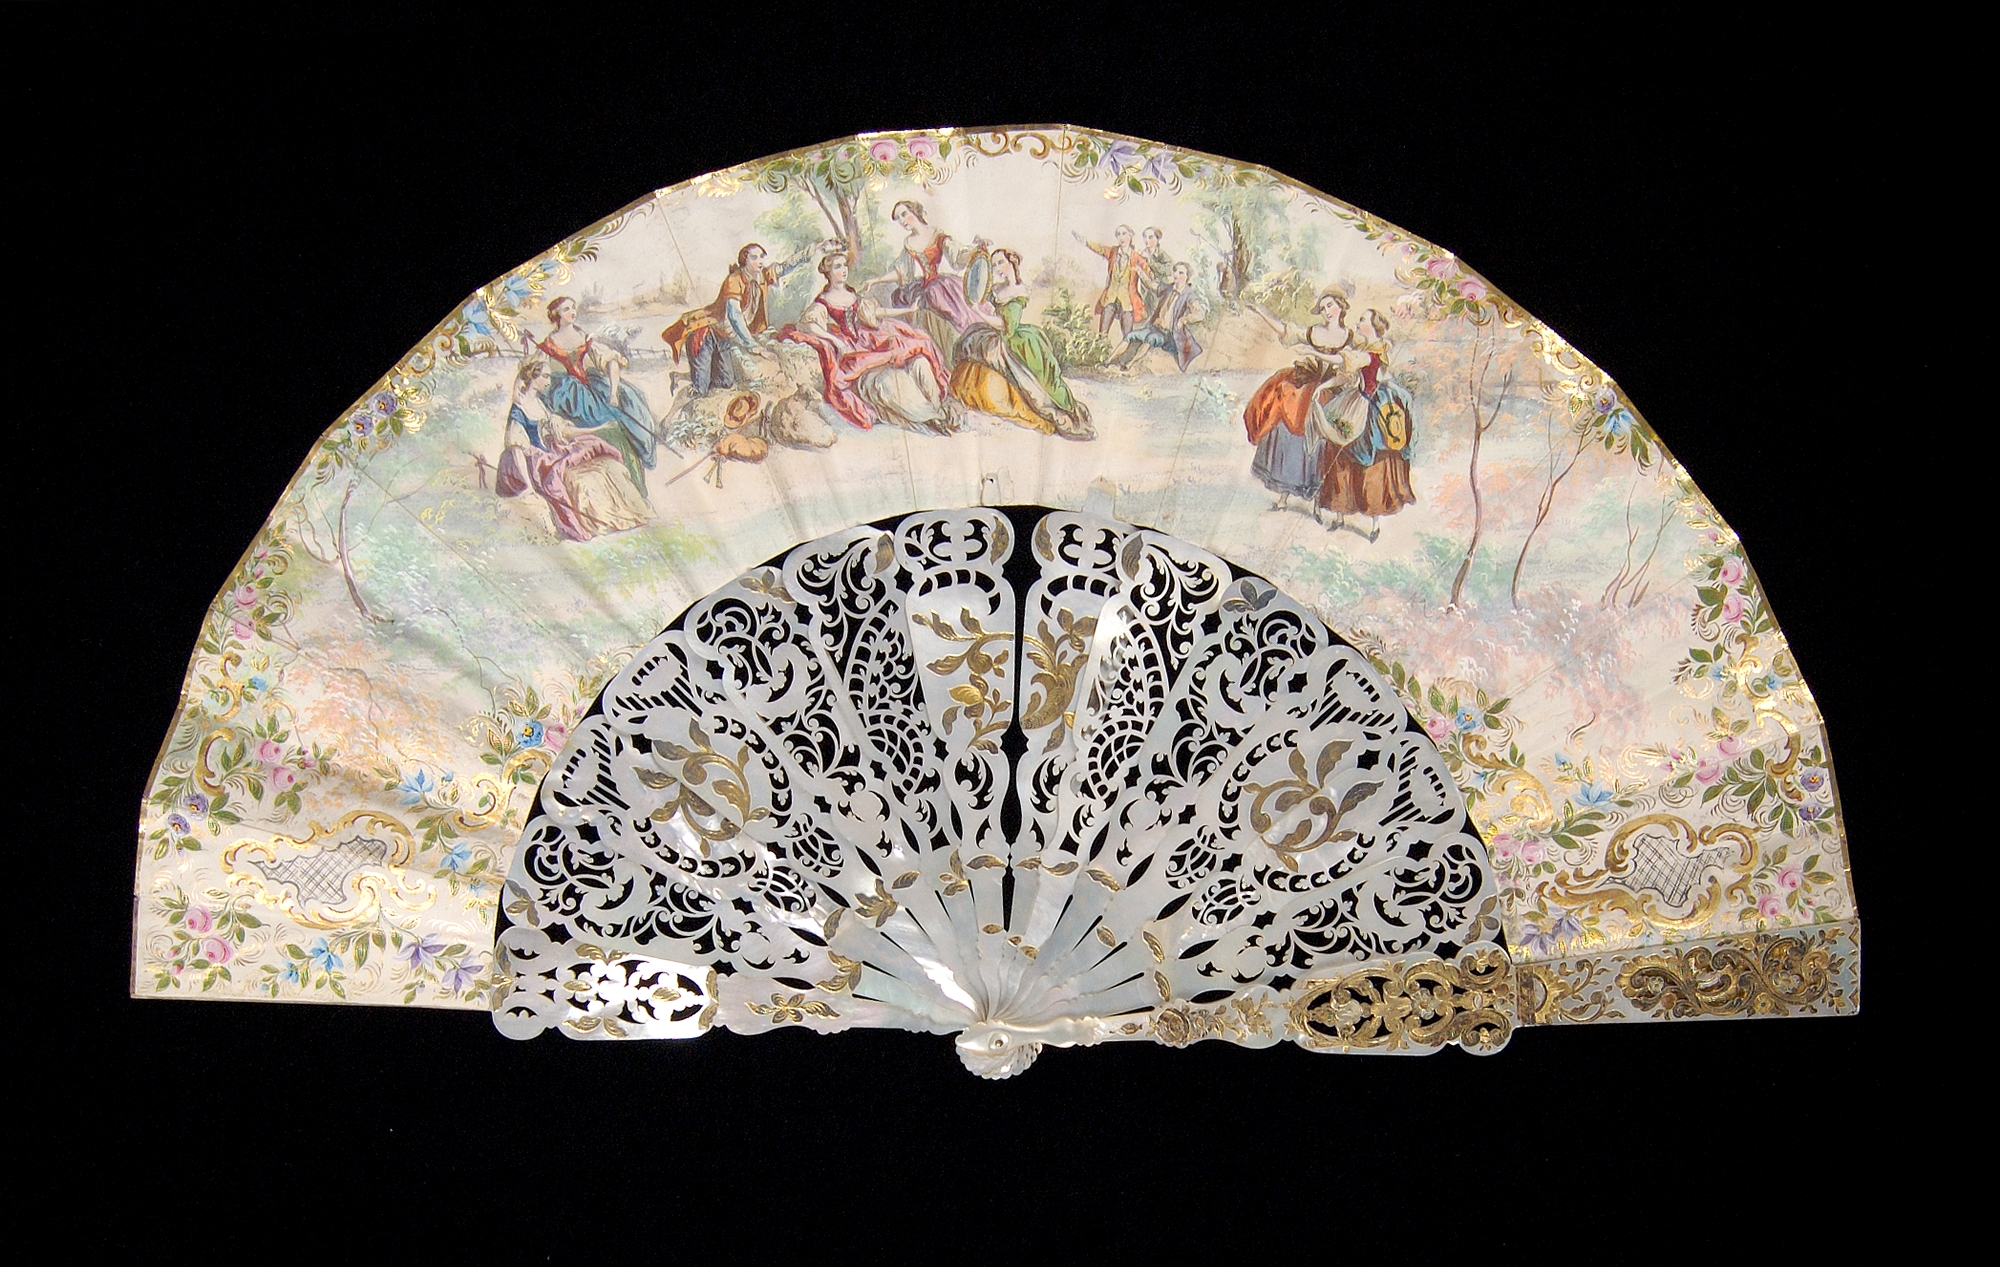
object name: fan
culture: european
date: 1855-1865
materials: mother of pearl, paper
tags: men,women